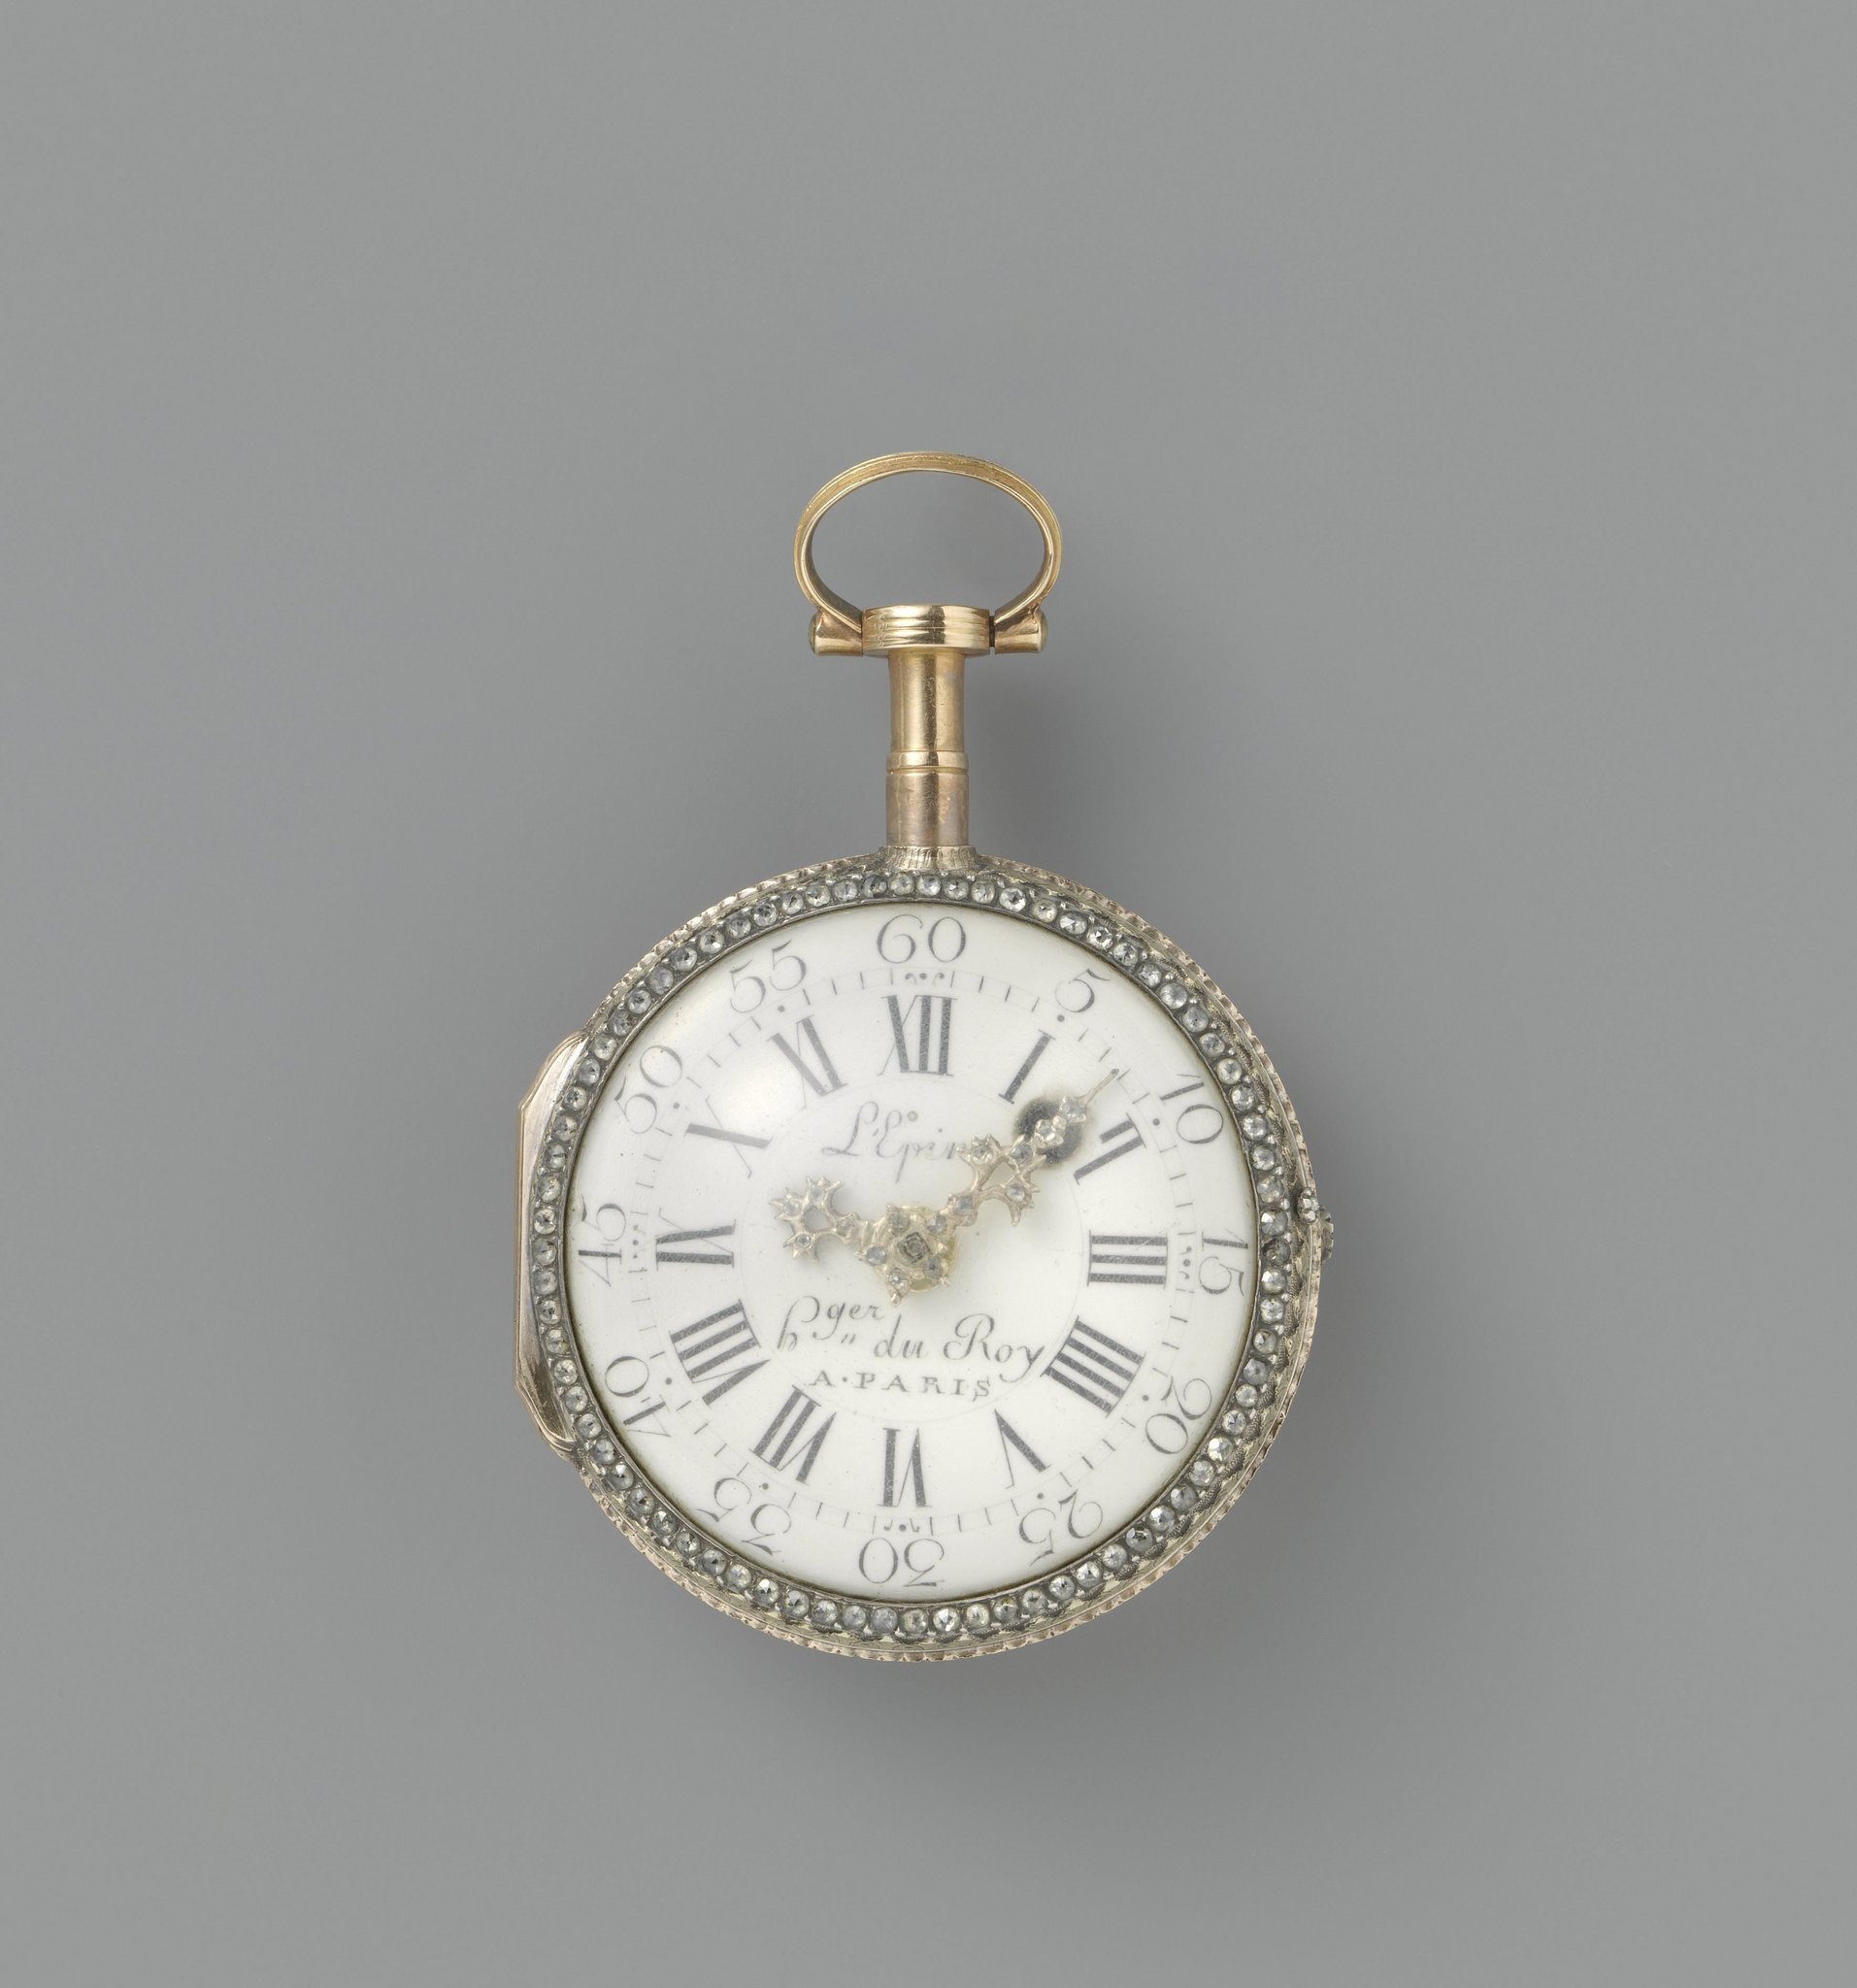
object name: pocket watch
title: Escapement Watch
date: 1777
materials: diamond, glass, gold, metal, silver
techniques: enameling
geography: paris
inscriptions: serial number: ‘2 489’, signature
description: Dit horloge behoort tot de vroegst bekende van de beroemde Parijse horlogemaker Jean Anthoine Lépine. Het nummer onder de wijzerplaat is een serienummer; een exemplaar dat dankzij de merken in de kast (Parijs, 1778) met zekerheid kan worden gedateerd, is genummerd 3 053 (Veiling Auctorem Genève, 10-4-1992, nr. 111), een ander genummerd 2 025, heeft gehaltemerken voor 1777 (Chapiro 1988, p. 44).